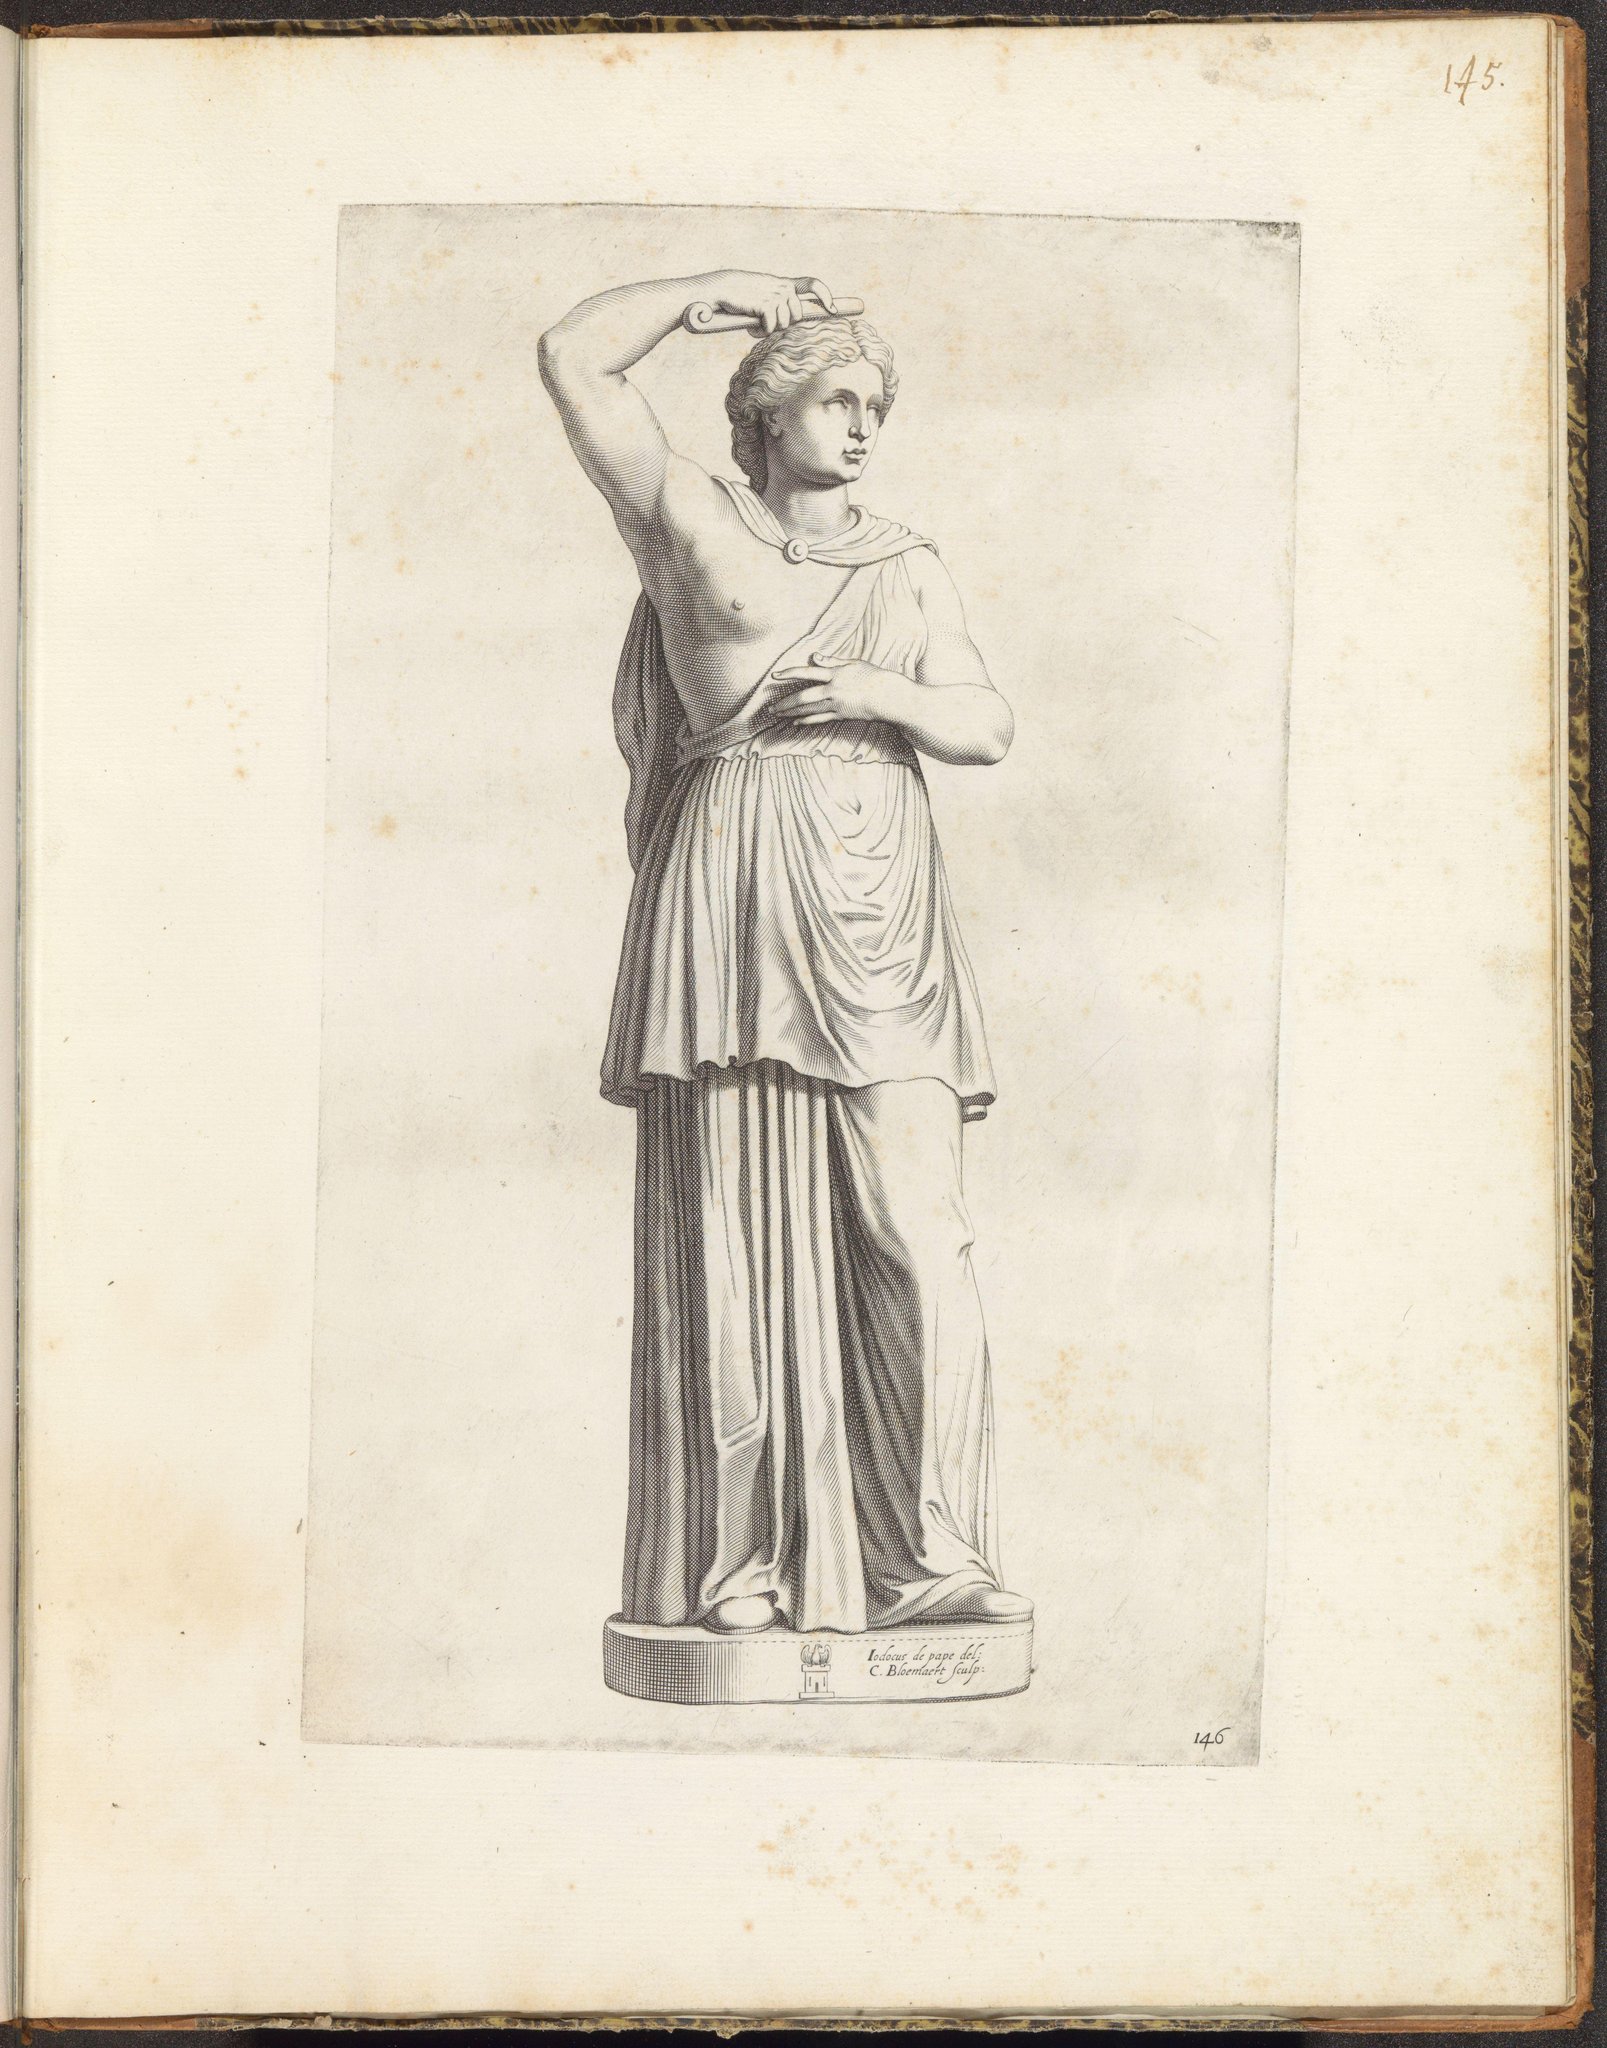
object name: print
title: Standbeeld van een vrouw die haar haar kamt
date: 1636-1647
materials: paper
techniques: engraving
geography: rome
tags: comb, brush and other tools (care of the hair), piece of sculpture, reproduction of a piece of sculpture, care of the hair - aa - ~ women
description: Standbeeld van een vrouw die haar haar kamt. Haar linker borst is ontbloot. Midden onder op de basis het wapenschild van Vincenzo Giustiniani. Prent maakt deel uit van een album met een serie prenten naar de sculpturen in de verzameling in de Galleria Giustiniani te Rome.